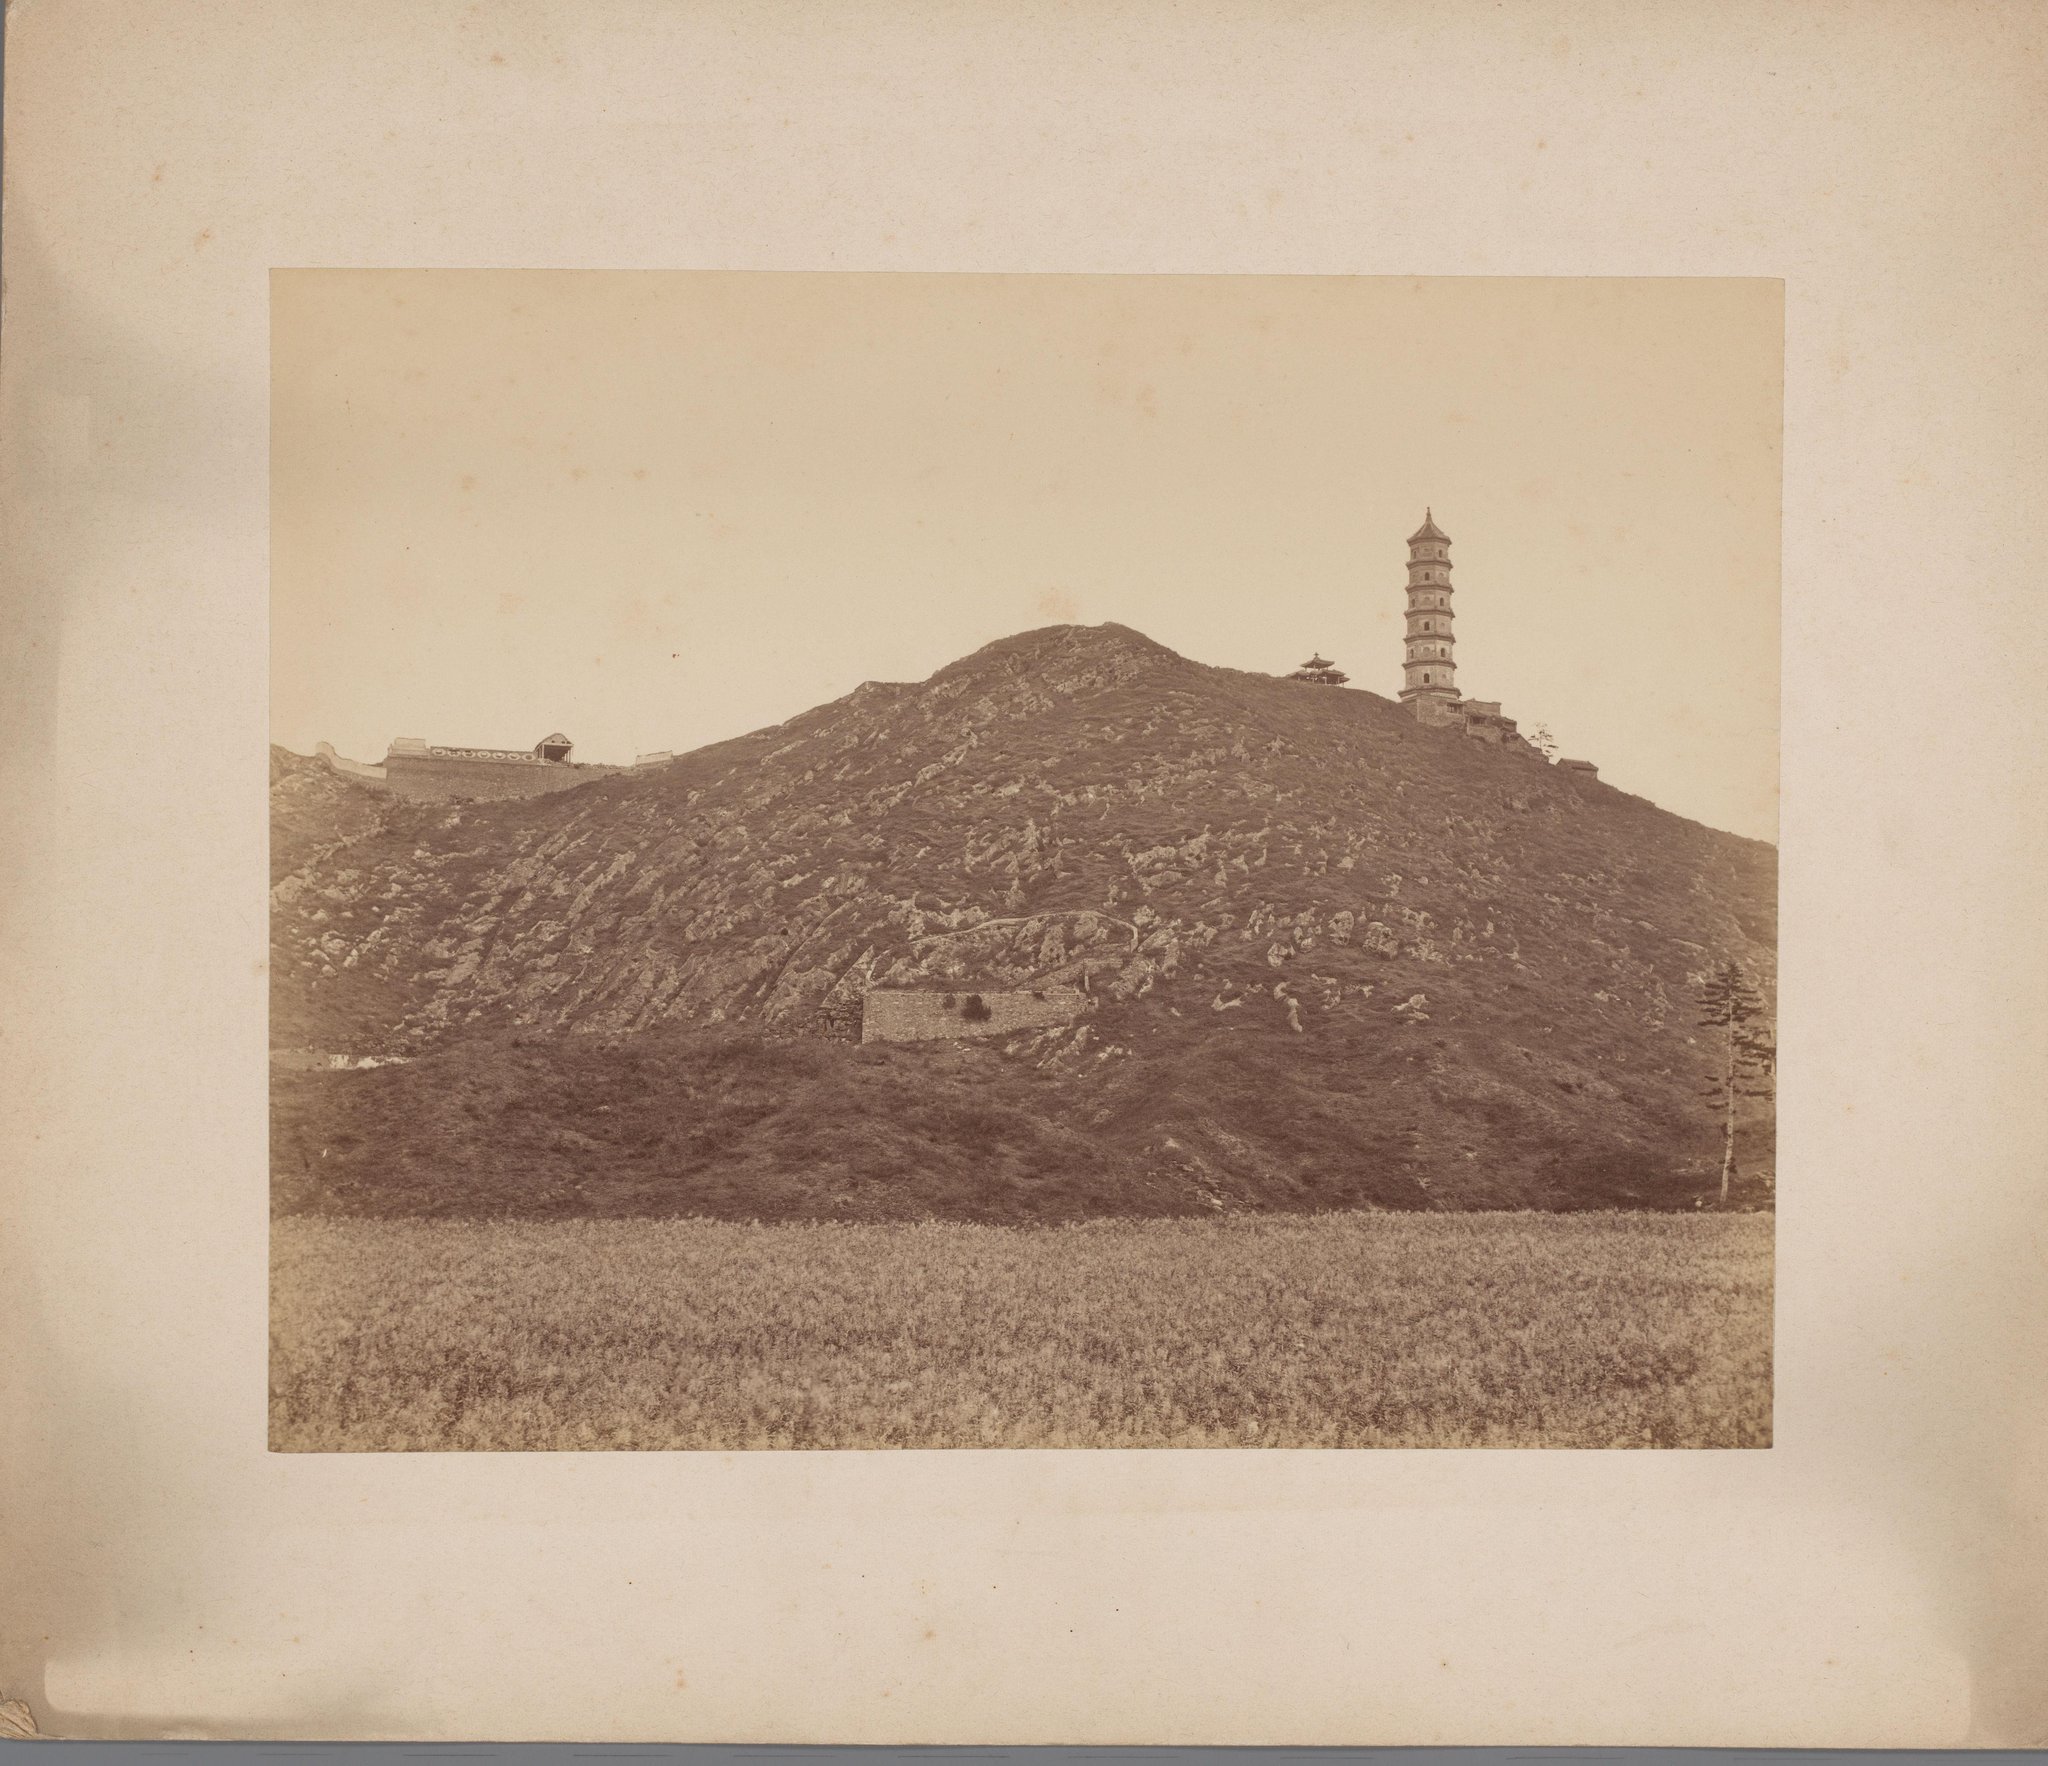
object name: photograph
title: Gezicht op de Jade Peak pagode te Beijing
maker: Anonymous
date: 1860-1900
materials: cardboard, photographic support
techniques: albumen print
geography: beijing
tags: temple, shrine ~ hinduism, buddhism, jainism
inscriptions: annotation: ‘No. 881, Yu-Ch'uan-shan/ This hill is also descernable from Wan-shou-shan. The pagoda consists of seven stories very plain in its structure.’